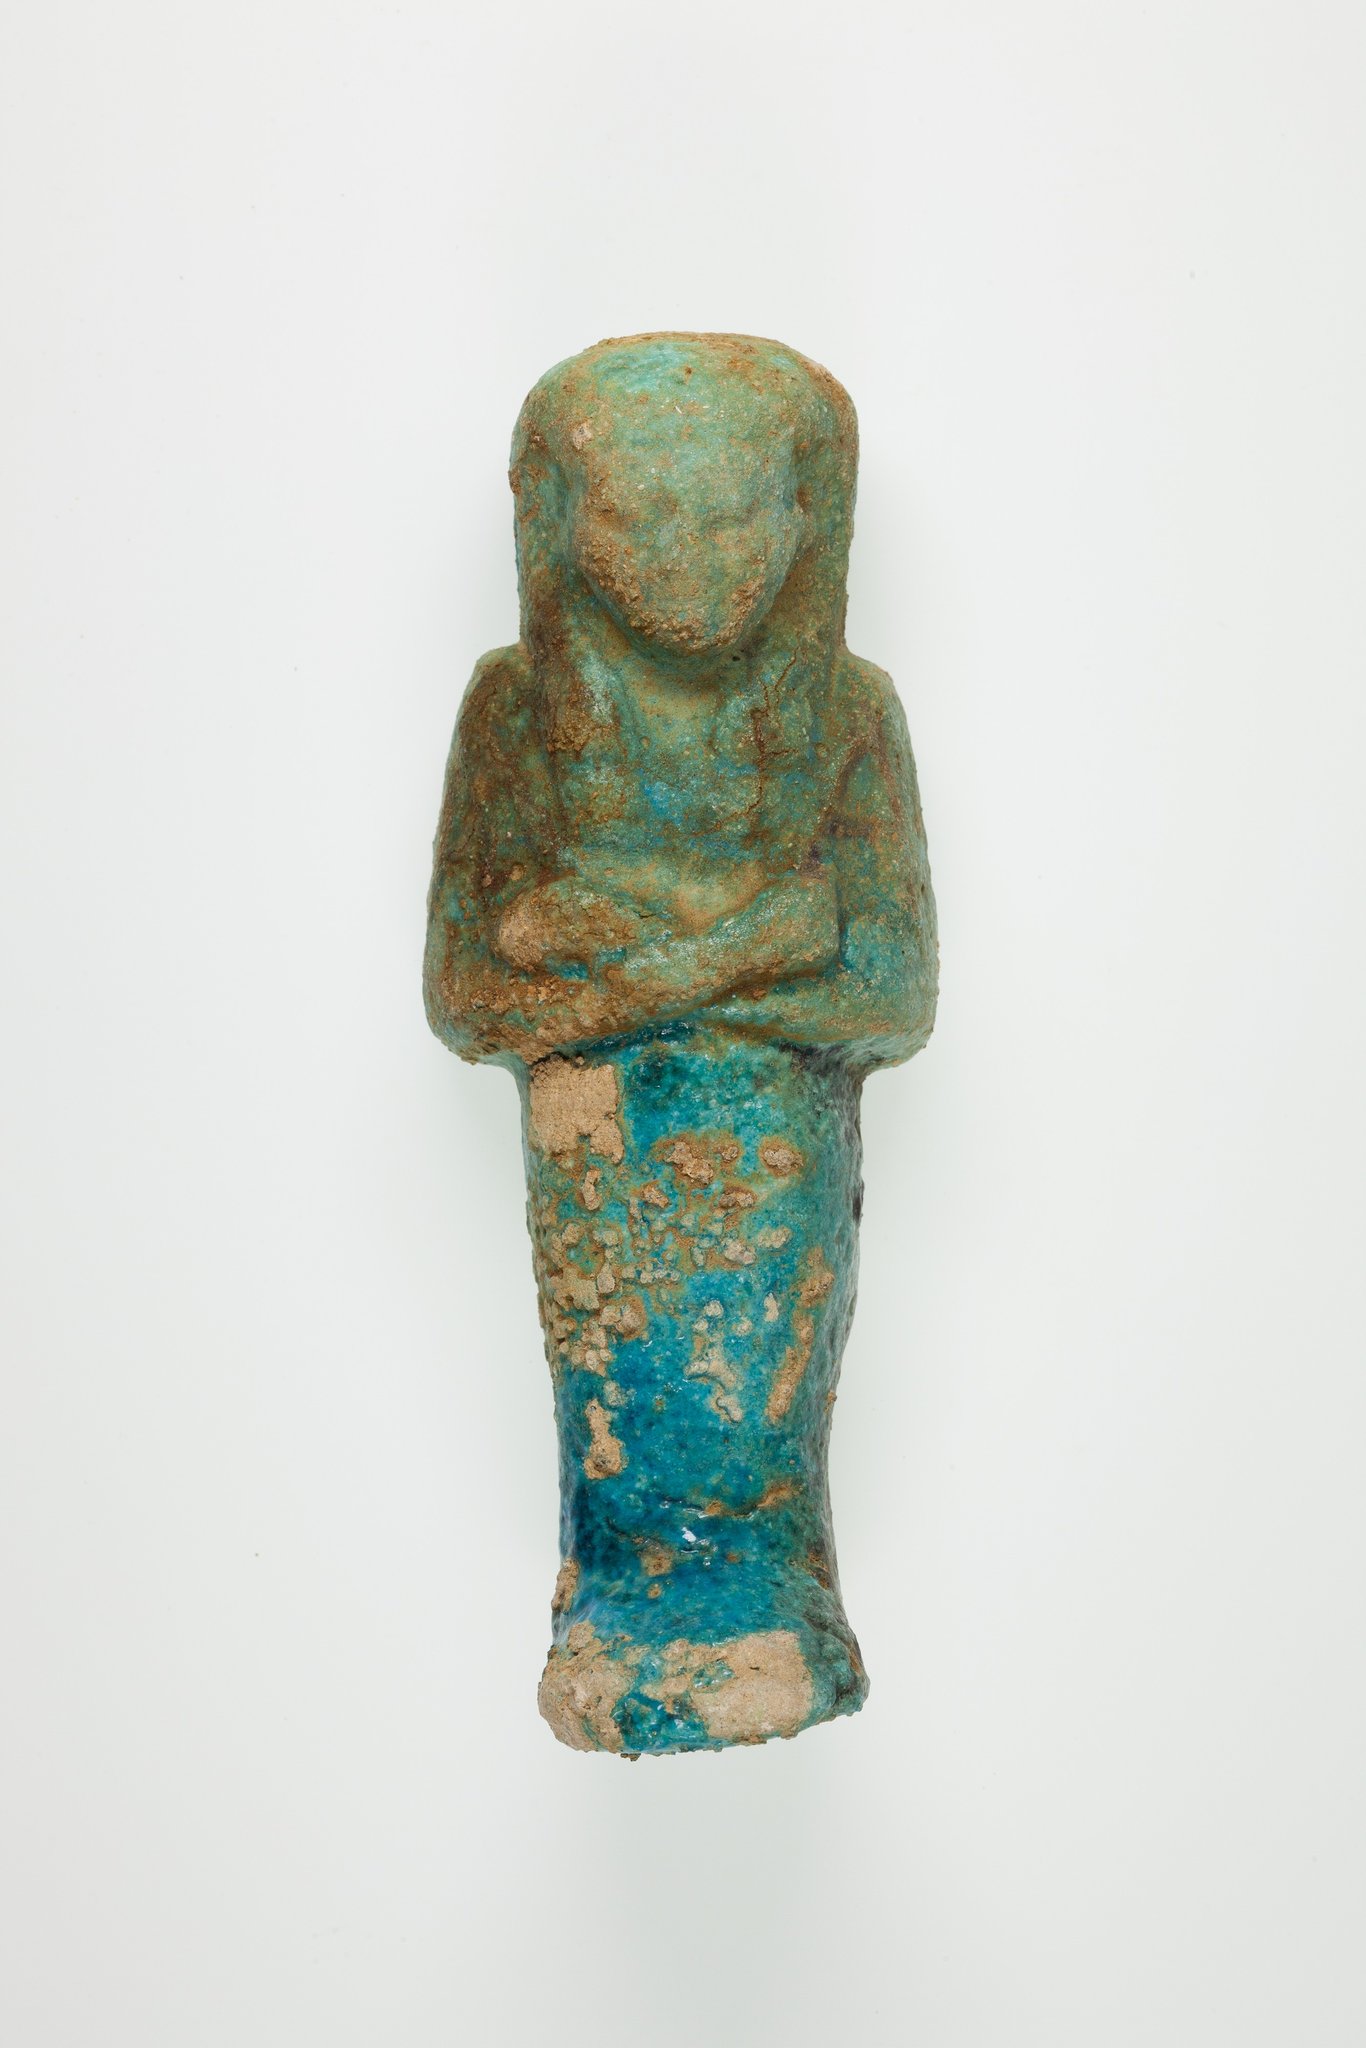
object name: shabti, henettawy c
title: Worker Shabti of Henettawy (C), Daughter of Isetemkheb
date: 990-970 BCE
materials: faience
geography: egypt